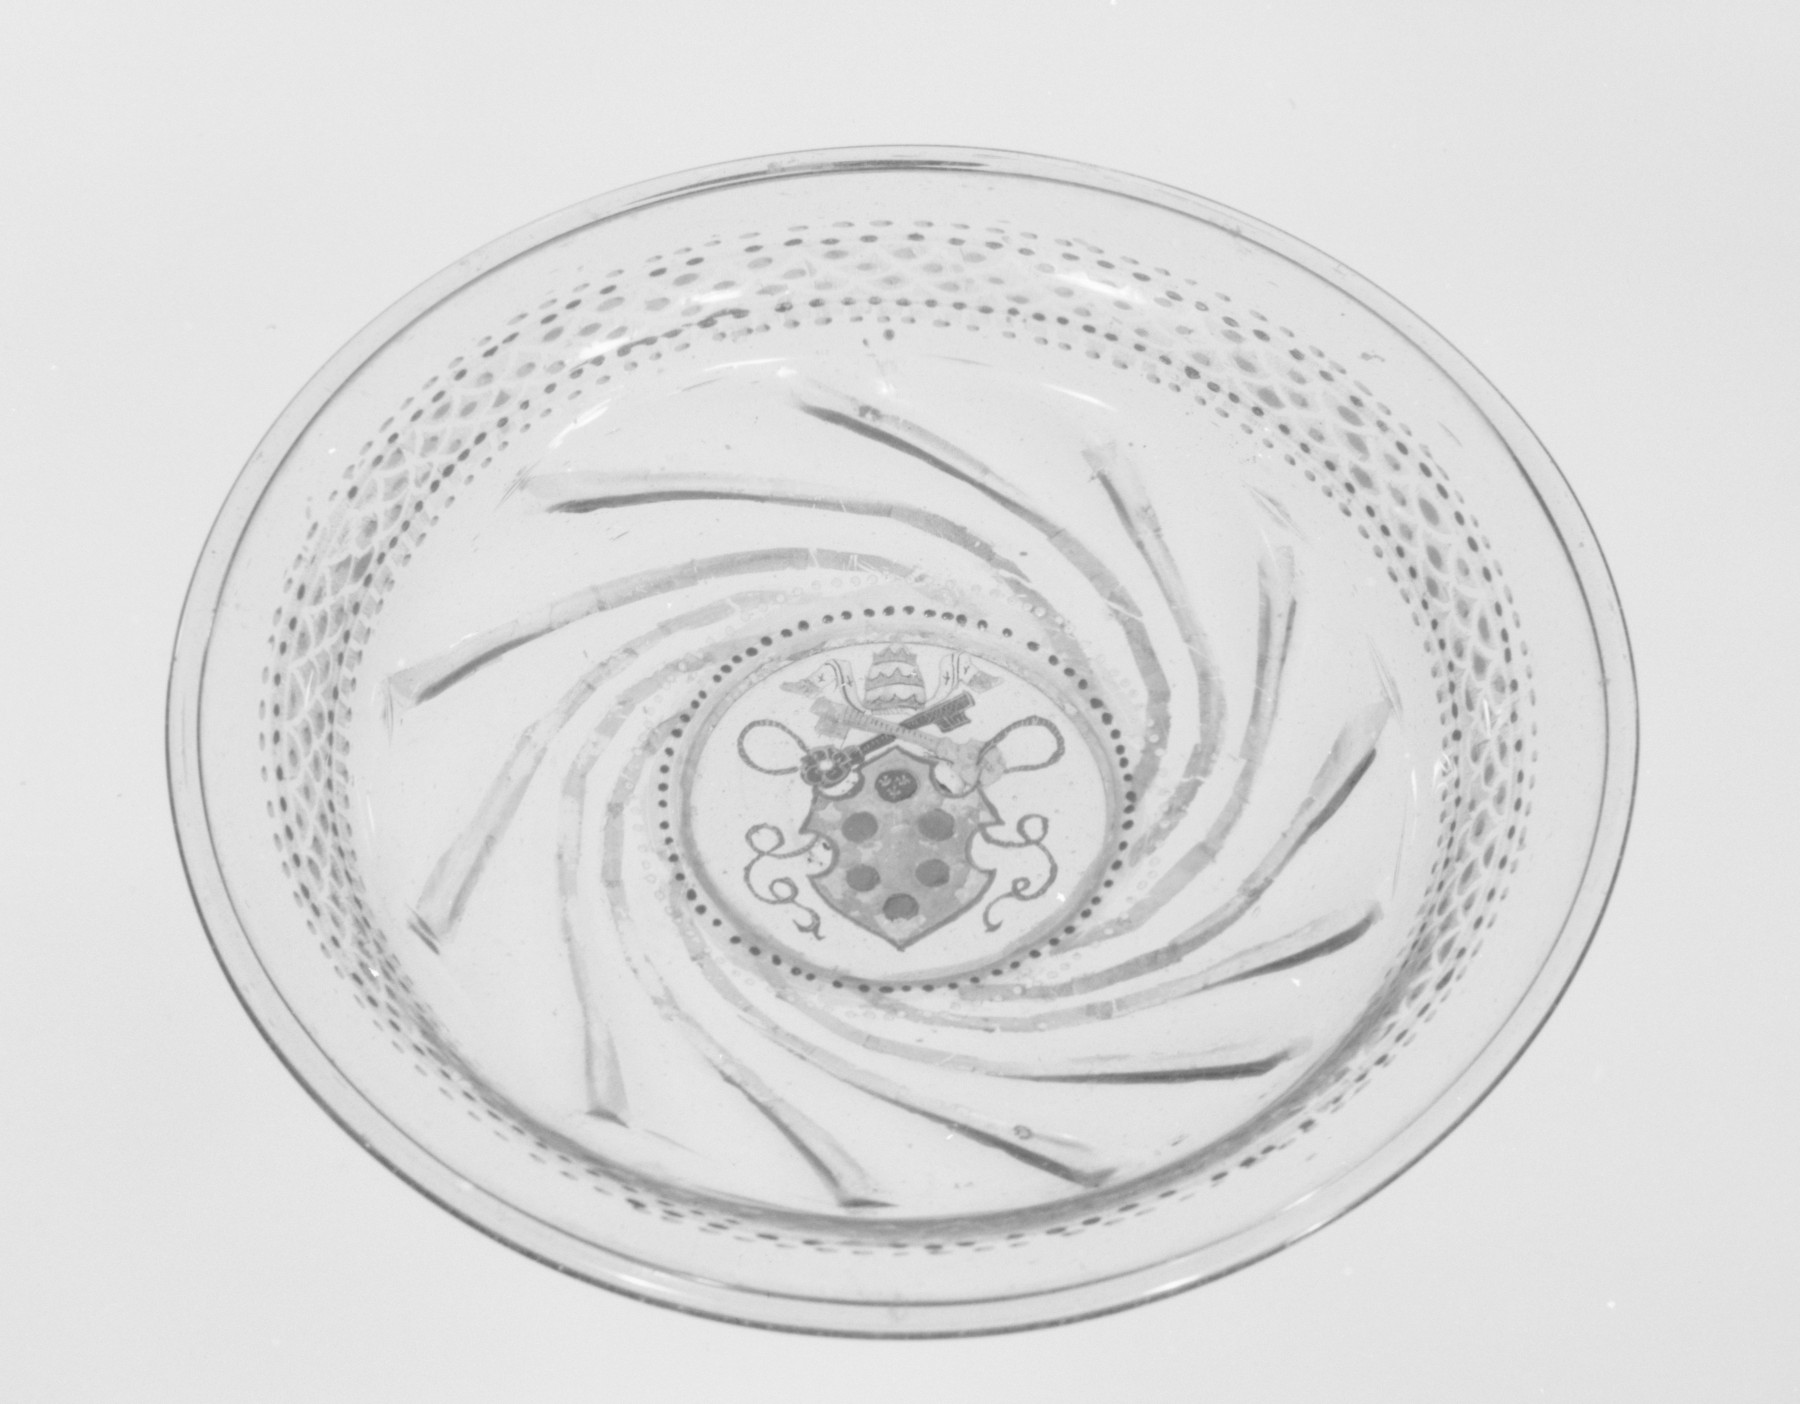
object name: tazza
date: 1513-1534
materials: glass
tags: coat of arms